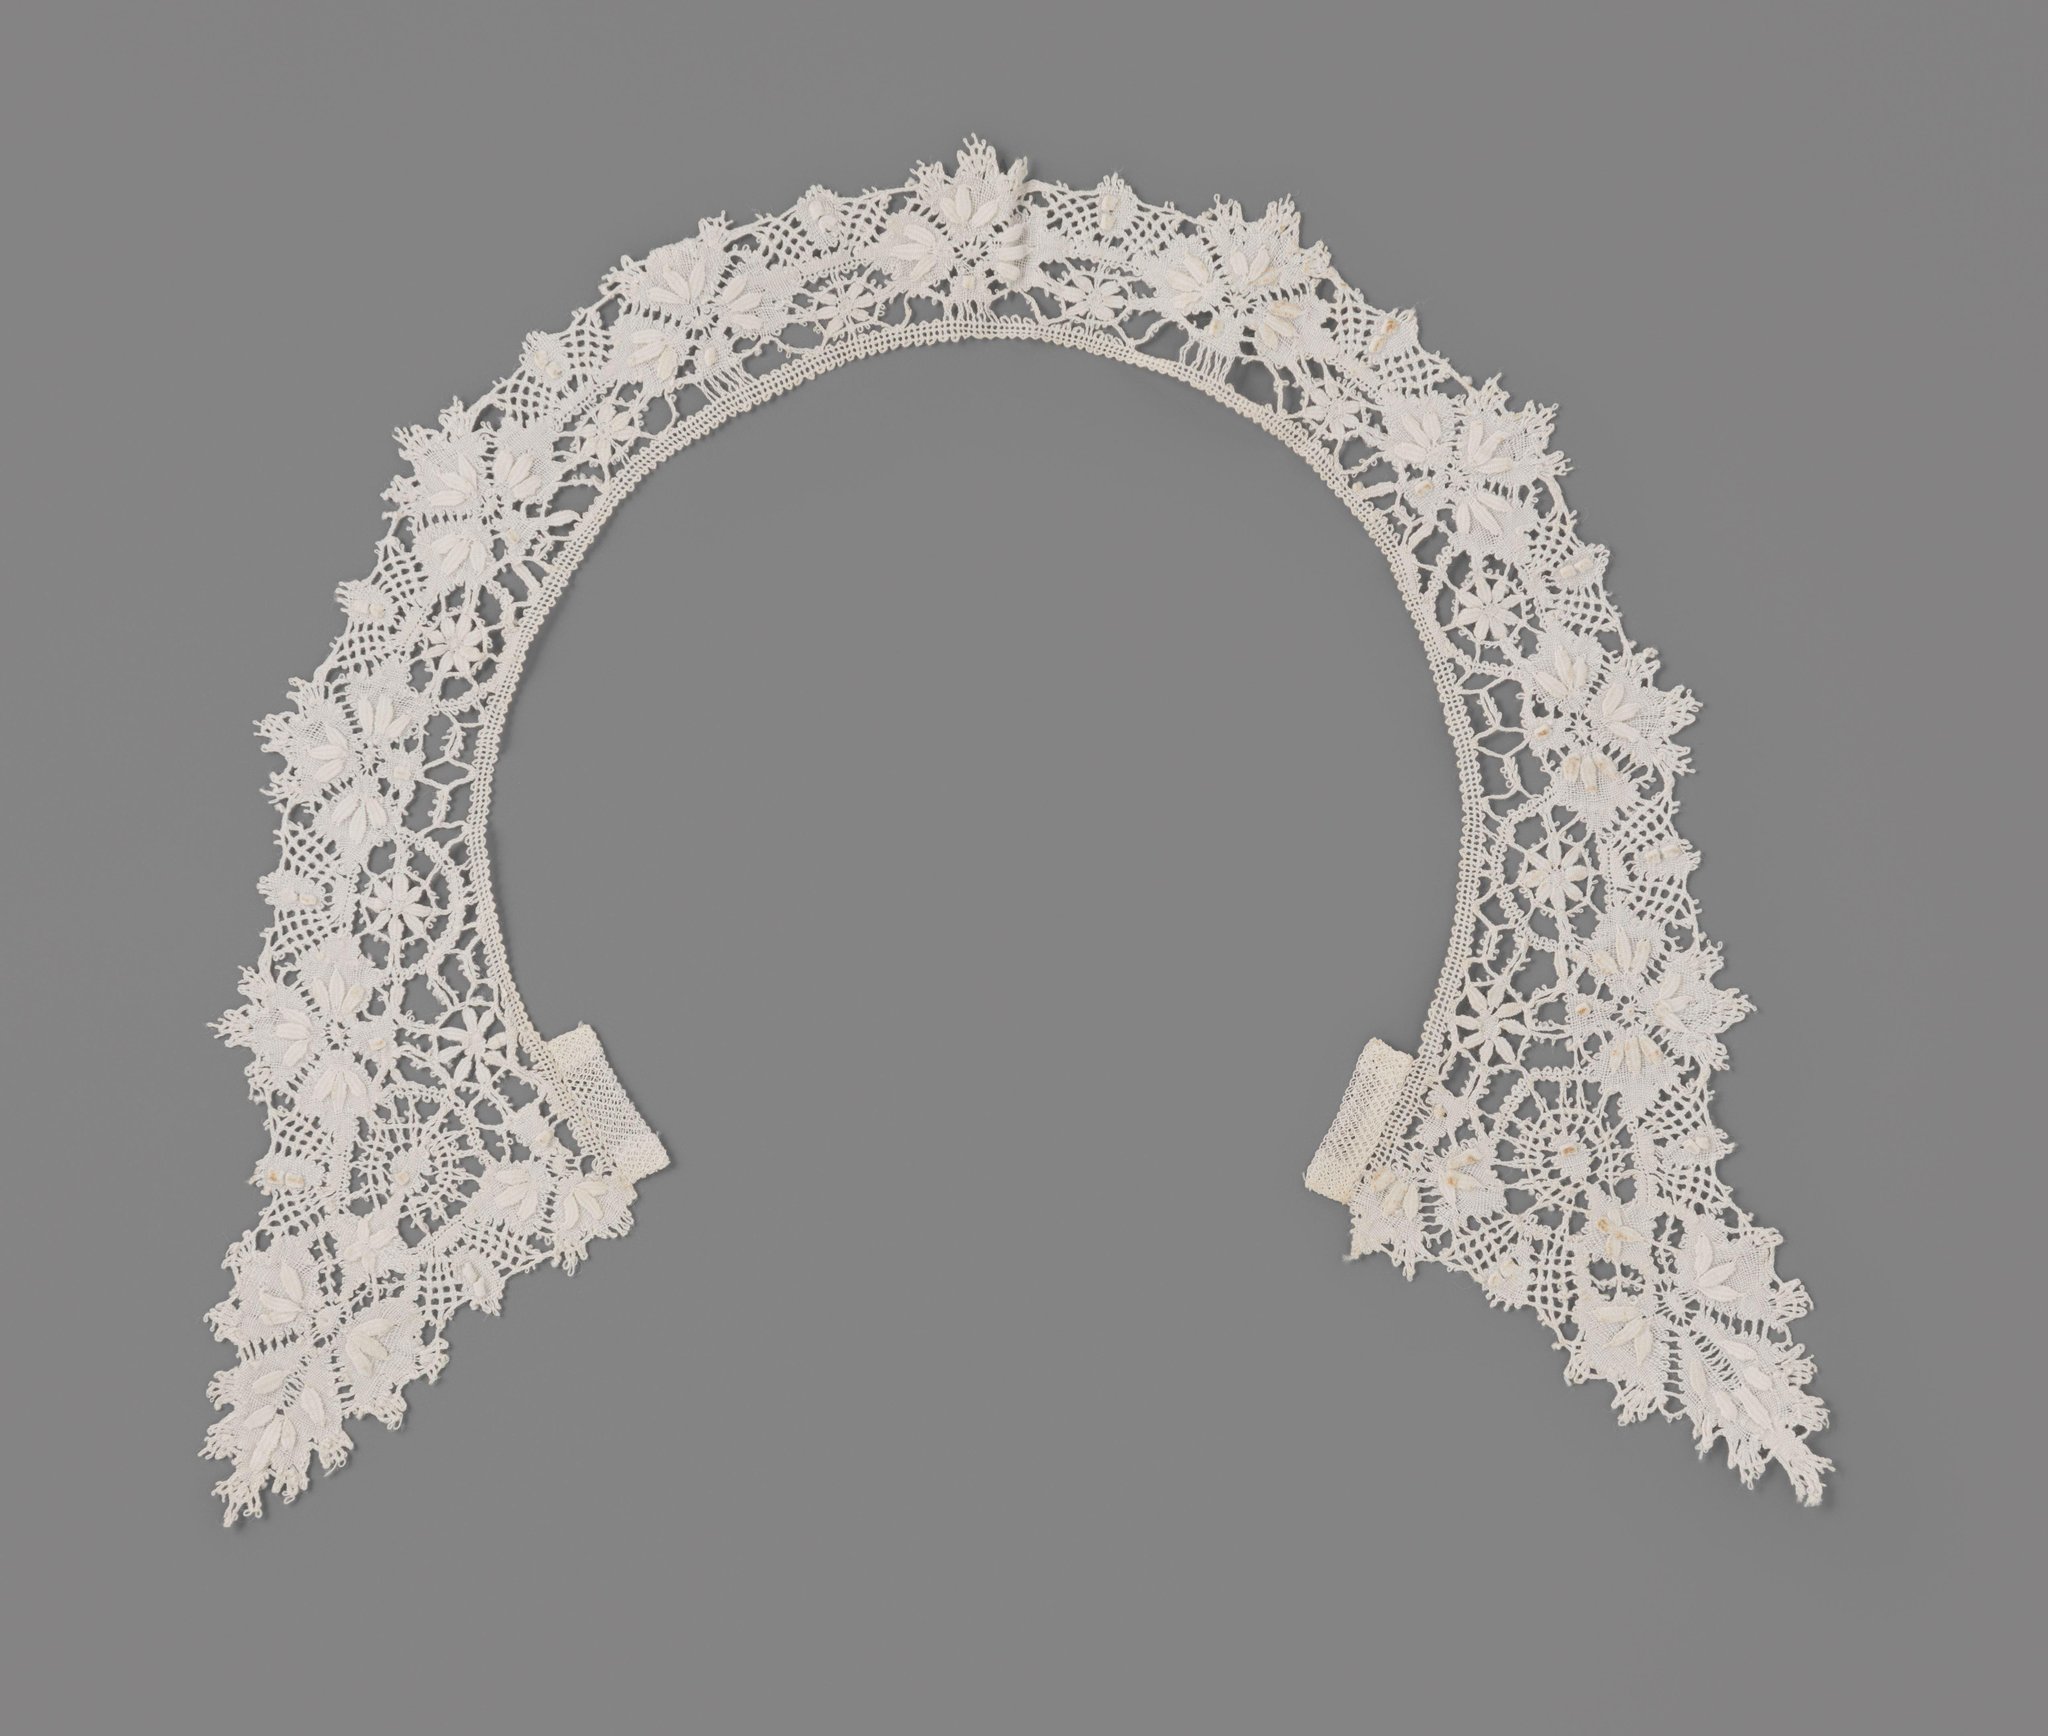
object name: clothing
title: Ronde liggende kraag van Clunykant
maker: Anonymous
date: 1910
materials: lace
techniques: lace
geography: le puy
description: Ronde liggende kraag van Clunykant met punten op de hoeken. De versiering bestaat uit twee randen, waarvan de onderste is gepicoteerd en is voorzien van bladeren afgewisseld met traliewerk, de rand daarboven bestaat uit rozen in wielen.